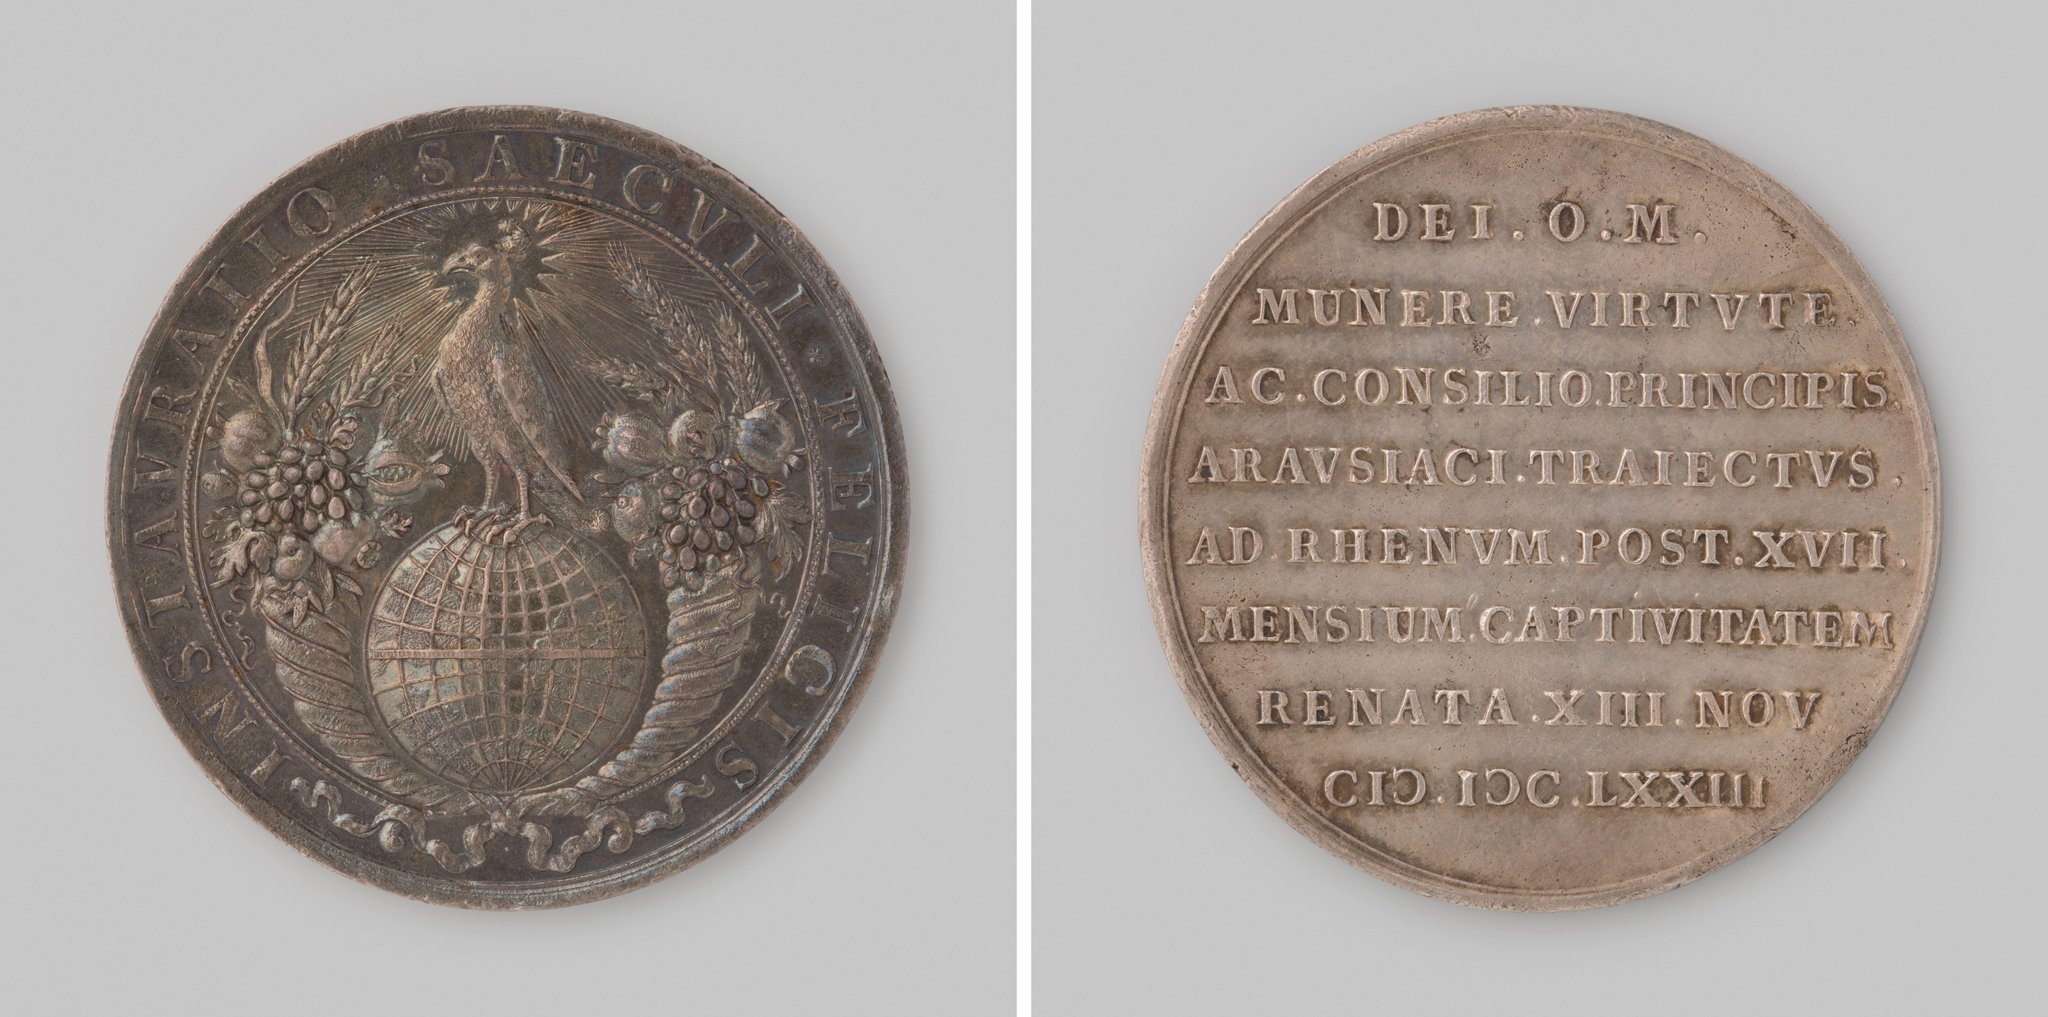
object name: history medal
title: Utrecht door de Fransen verlaten 1673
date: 1673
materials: silver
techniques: striking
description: Zilveren penning, op de voorzijde een stralende phoenix op globe tussen twee hoorns des overvloeds, met omschrift, op de keerzijde acht regels tekst.